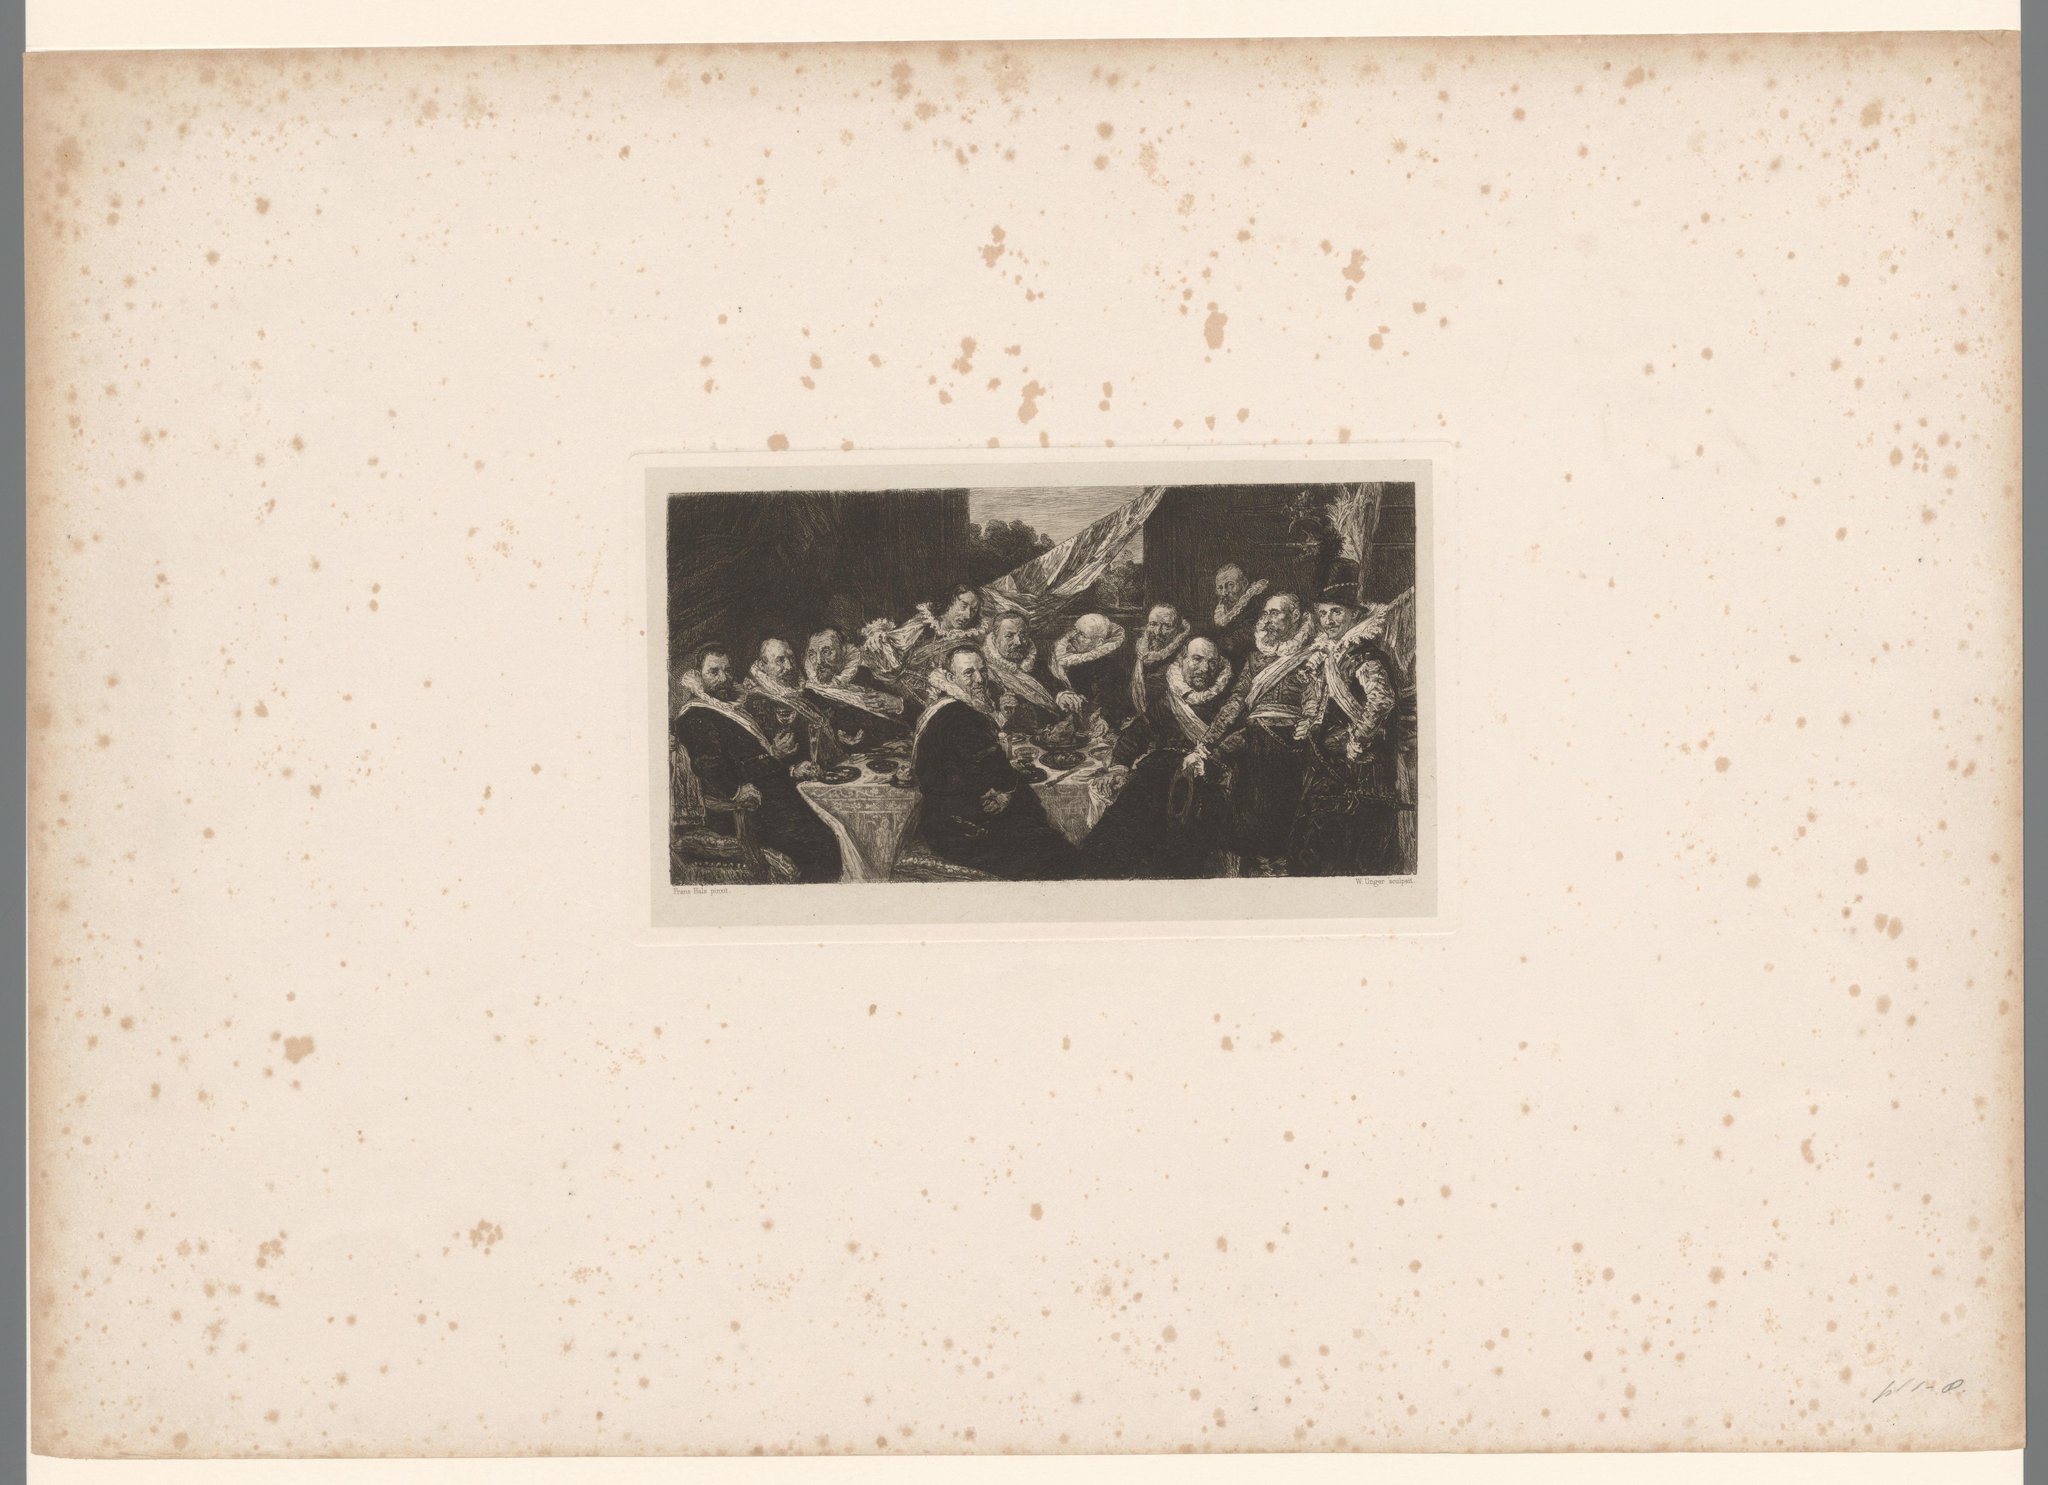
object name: print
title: Feestmaal van de officieren van de Haarlemse Sint Jorisschutterij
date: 1847-1889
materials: paper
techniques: etching, intaglio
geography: germany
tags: haarlem, mayor, (military) standard-bearer, warfare; military affairs (+ citizen soldiery, civil guard, citizen militia), celebration meal, feast, banquet, historical persons (portraits and scenes from the life)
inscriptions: collector's mark: Lugt 2228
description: Prent naar het schilderij door Frans Hals in het Frans Halsmuseum te Haarlem (inv.nr. os I-109).